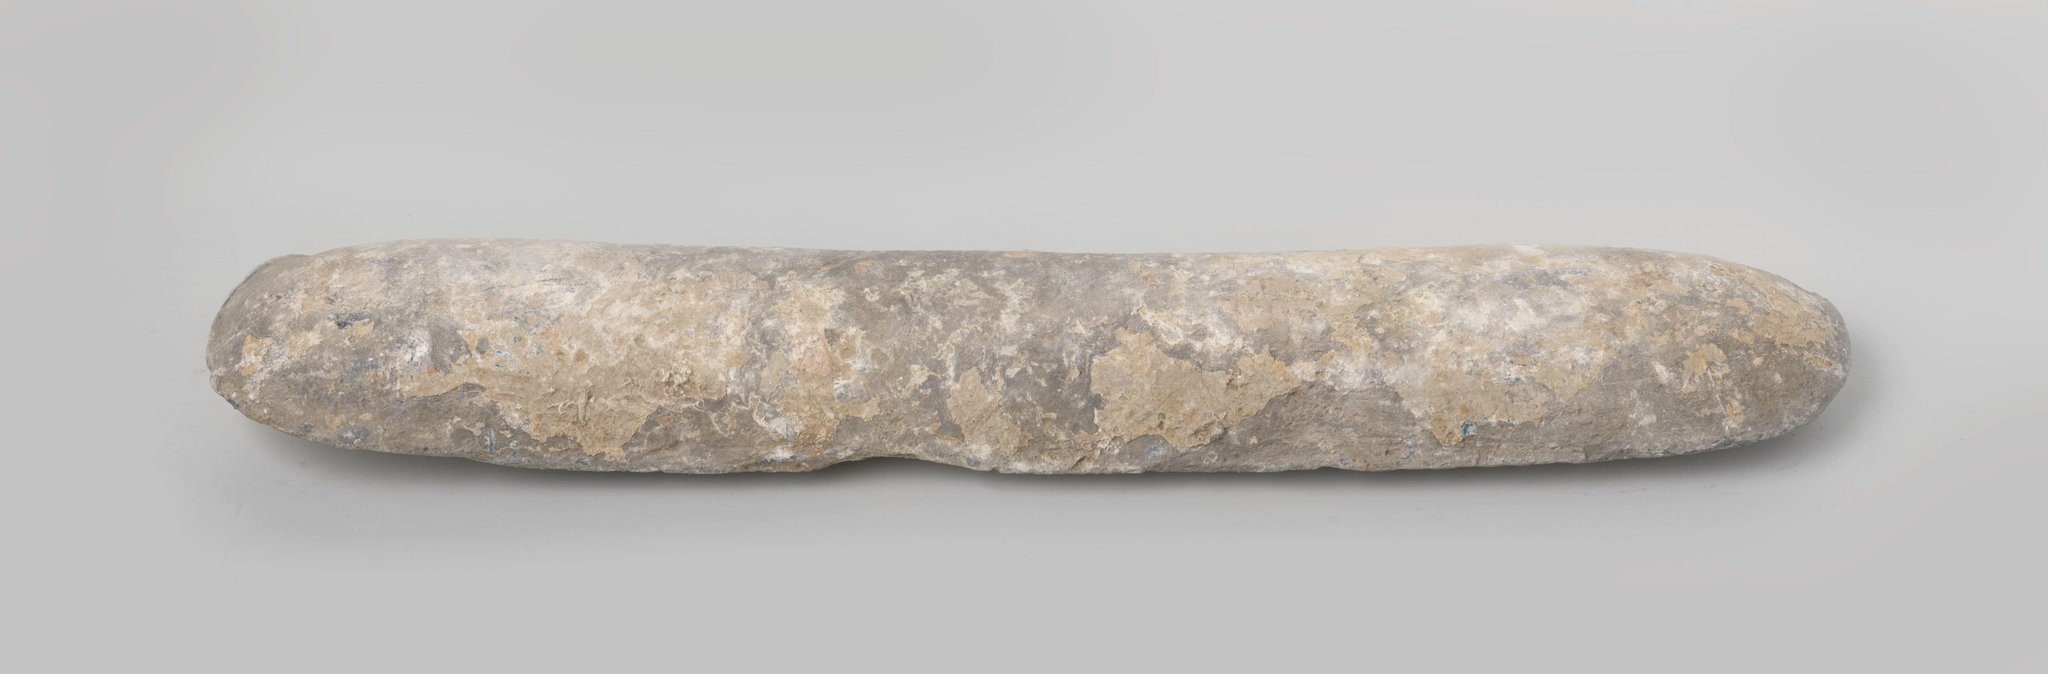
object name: ingot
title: Ballastlood afkomstig van de Oost-Indiëvaarder Hollandia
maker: Anonymous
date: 1700-1743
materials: lead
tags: verenigde oostindische compagnie, hollandia (schip)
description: Ballastlood afkomstig van de Oost-Indiëvaarder Hollandia. (Ingot).